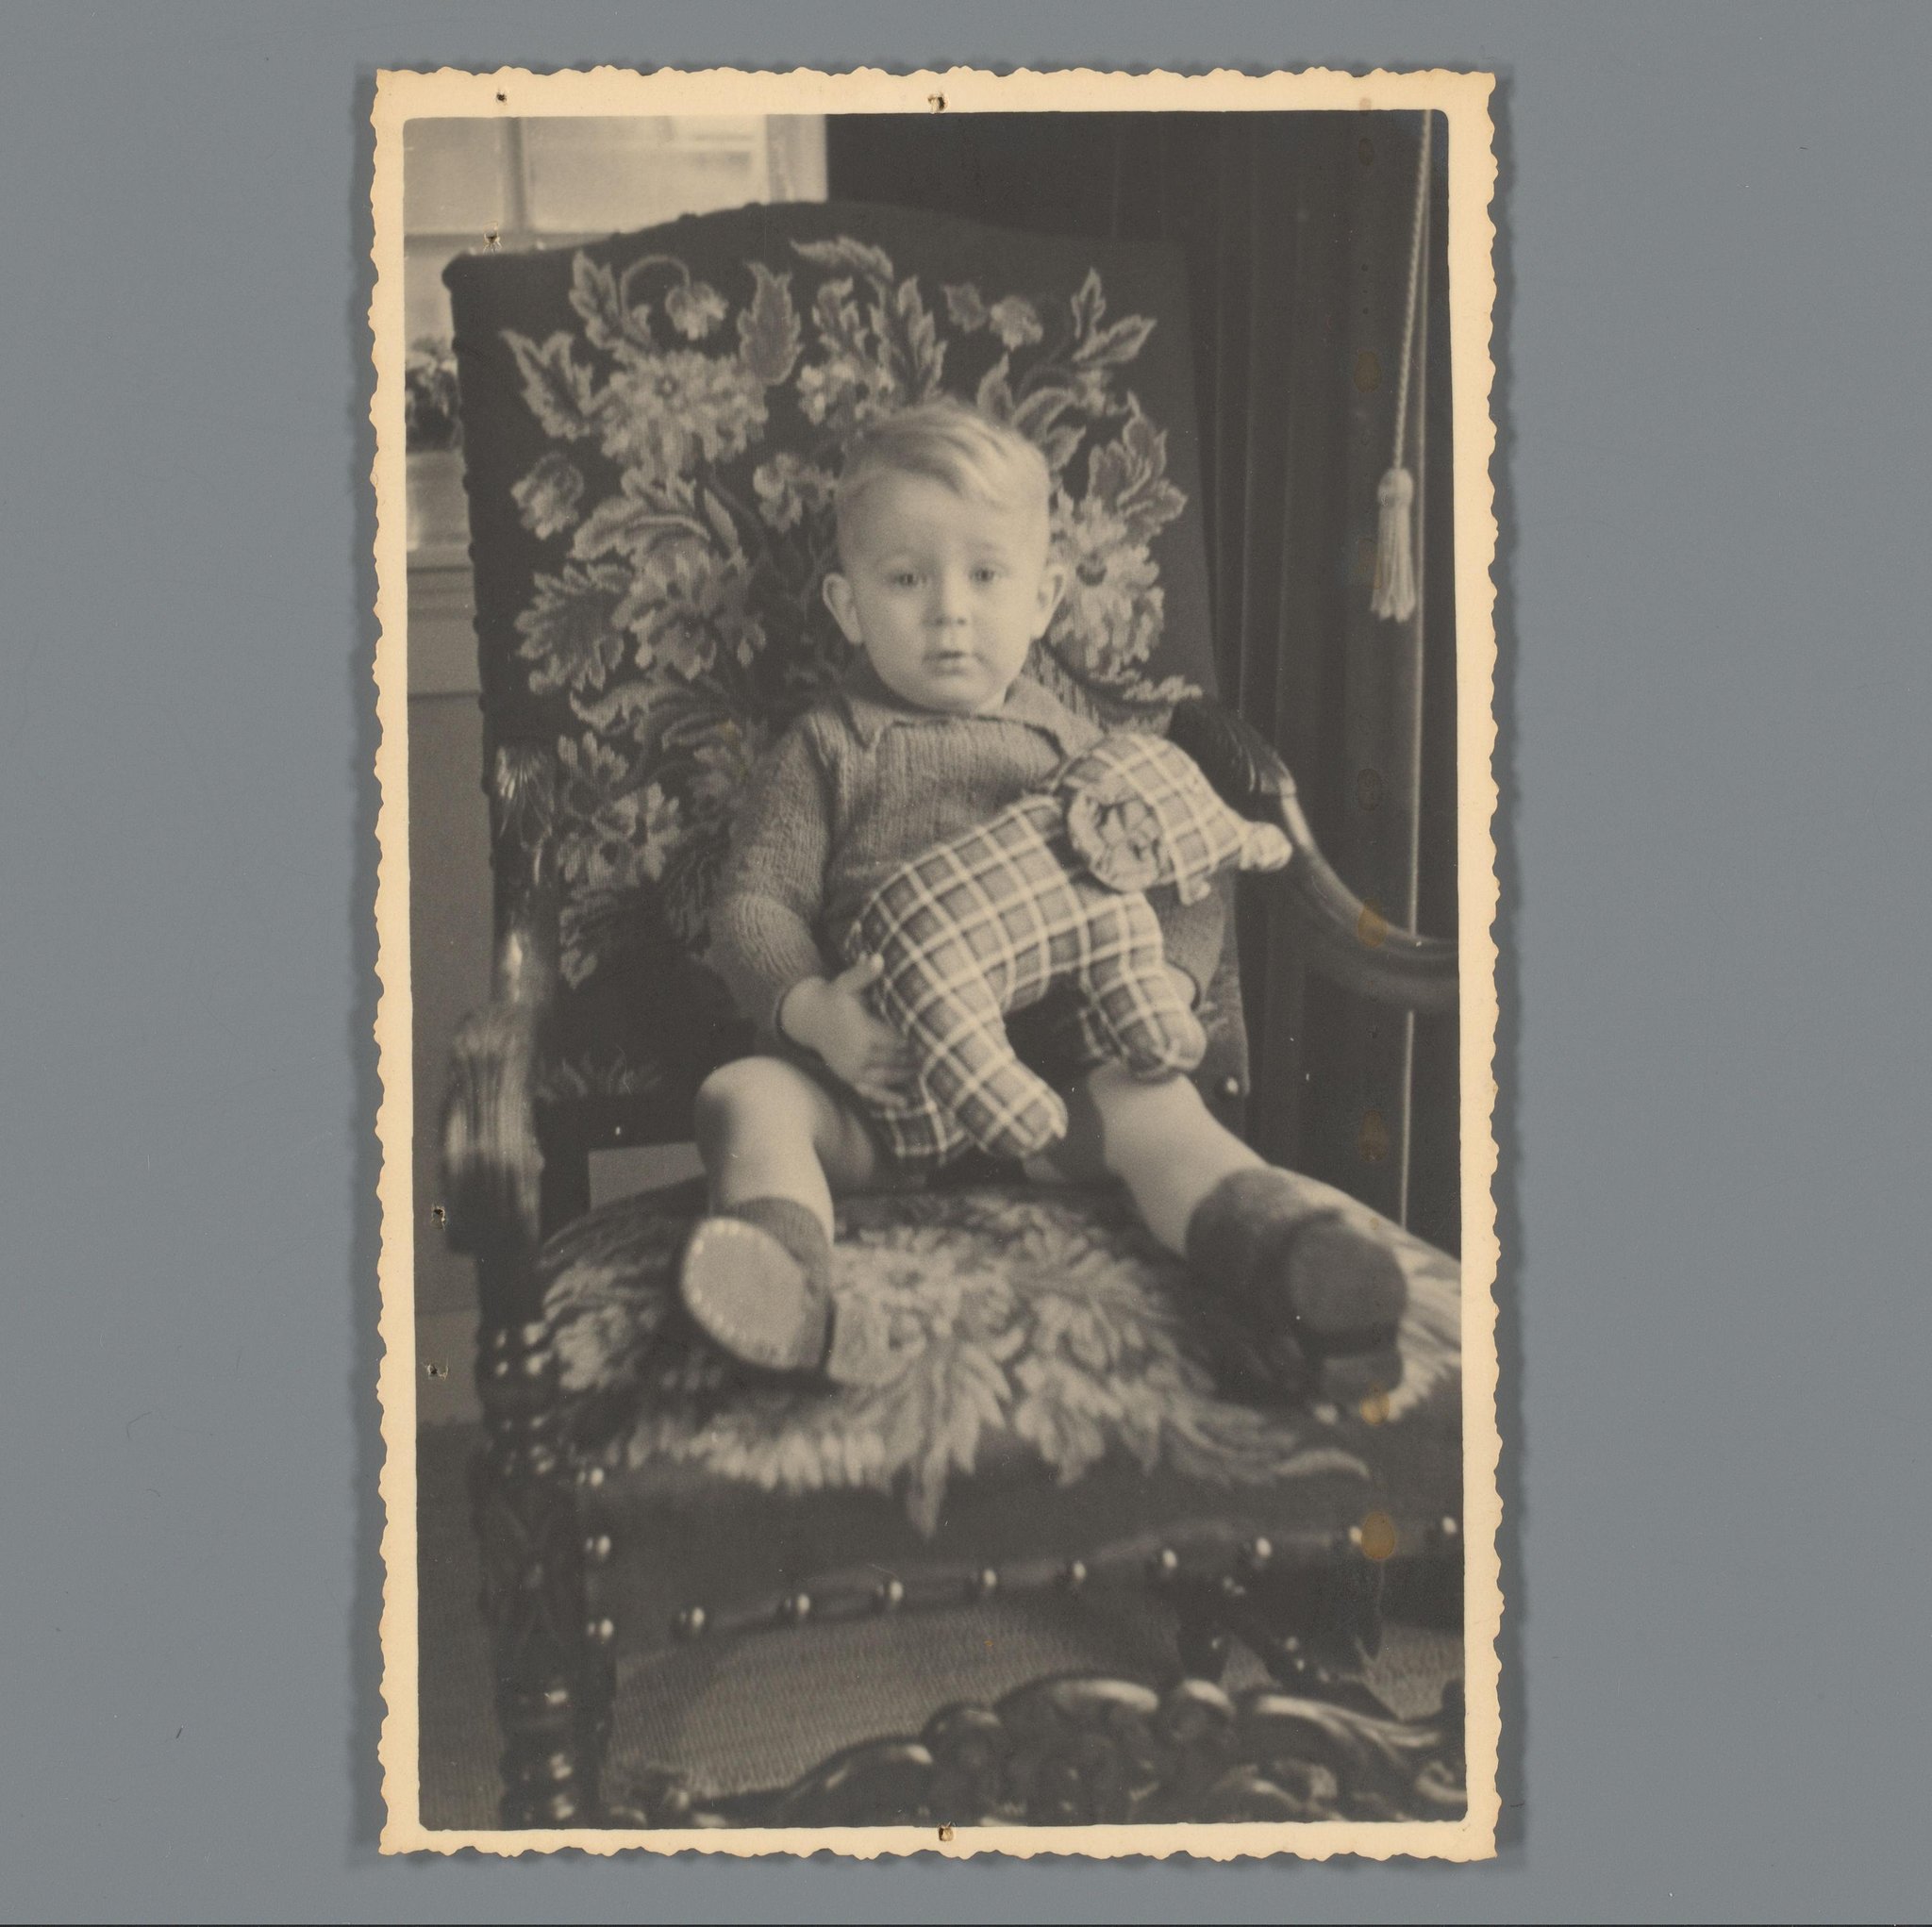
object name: photograph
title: Henk Swellengrebel als kind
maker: oosten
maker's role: fotograaf, fotohandel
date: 1944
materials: cardboard, photographic support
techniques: gelatin silver print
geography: delft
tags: historical persons, child (at home)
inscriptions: stamp: ‘Oflag 67 Geprüft 6’, inscription: ‘31/10/1944 Henk Delft’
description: Henk Swellengrebel als kind zittend in een stoel met speelgoedolifant. Foto uitgevoerd als prentbriefkaart.